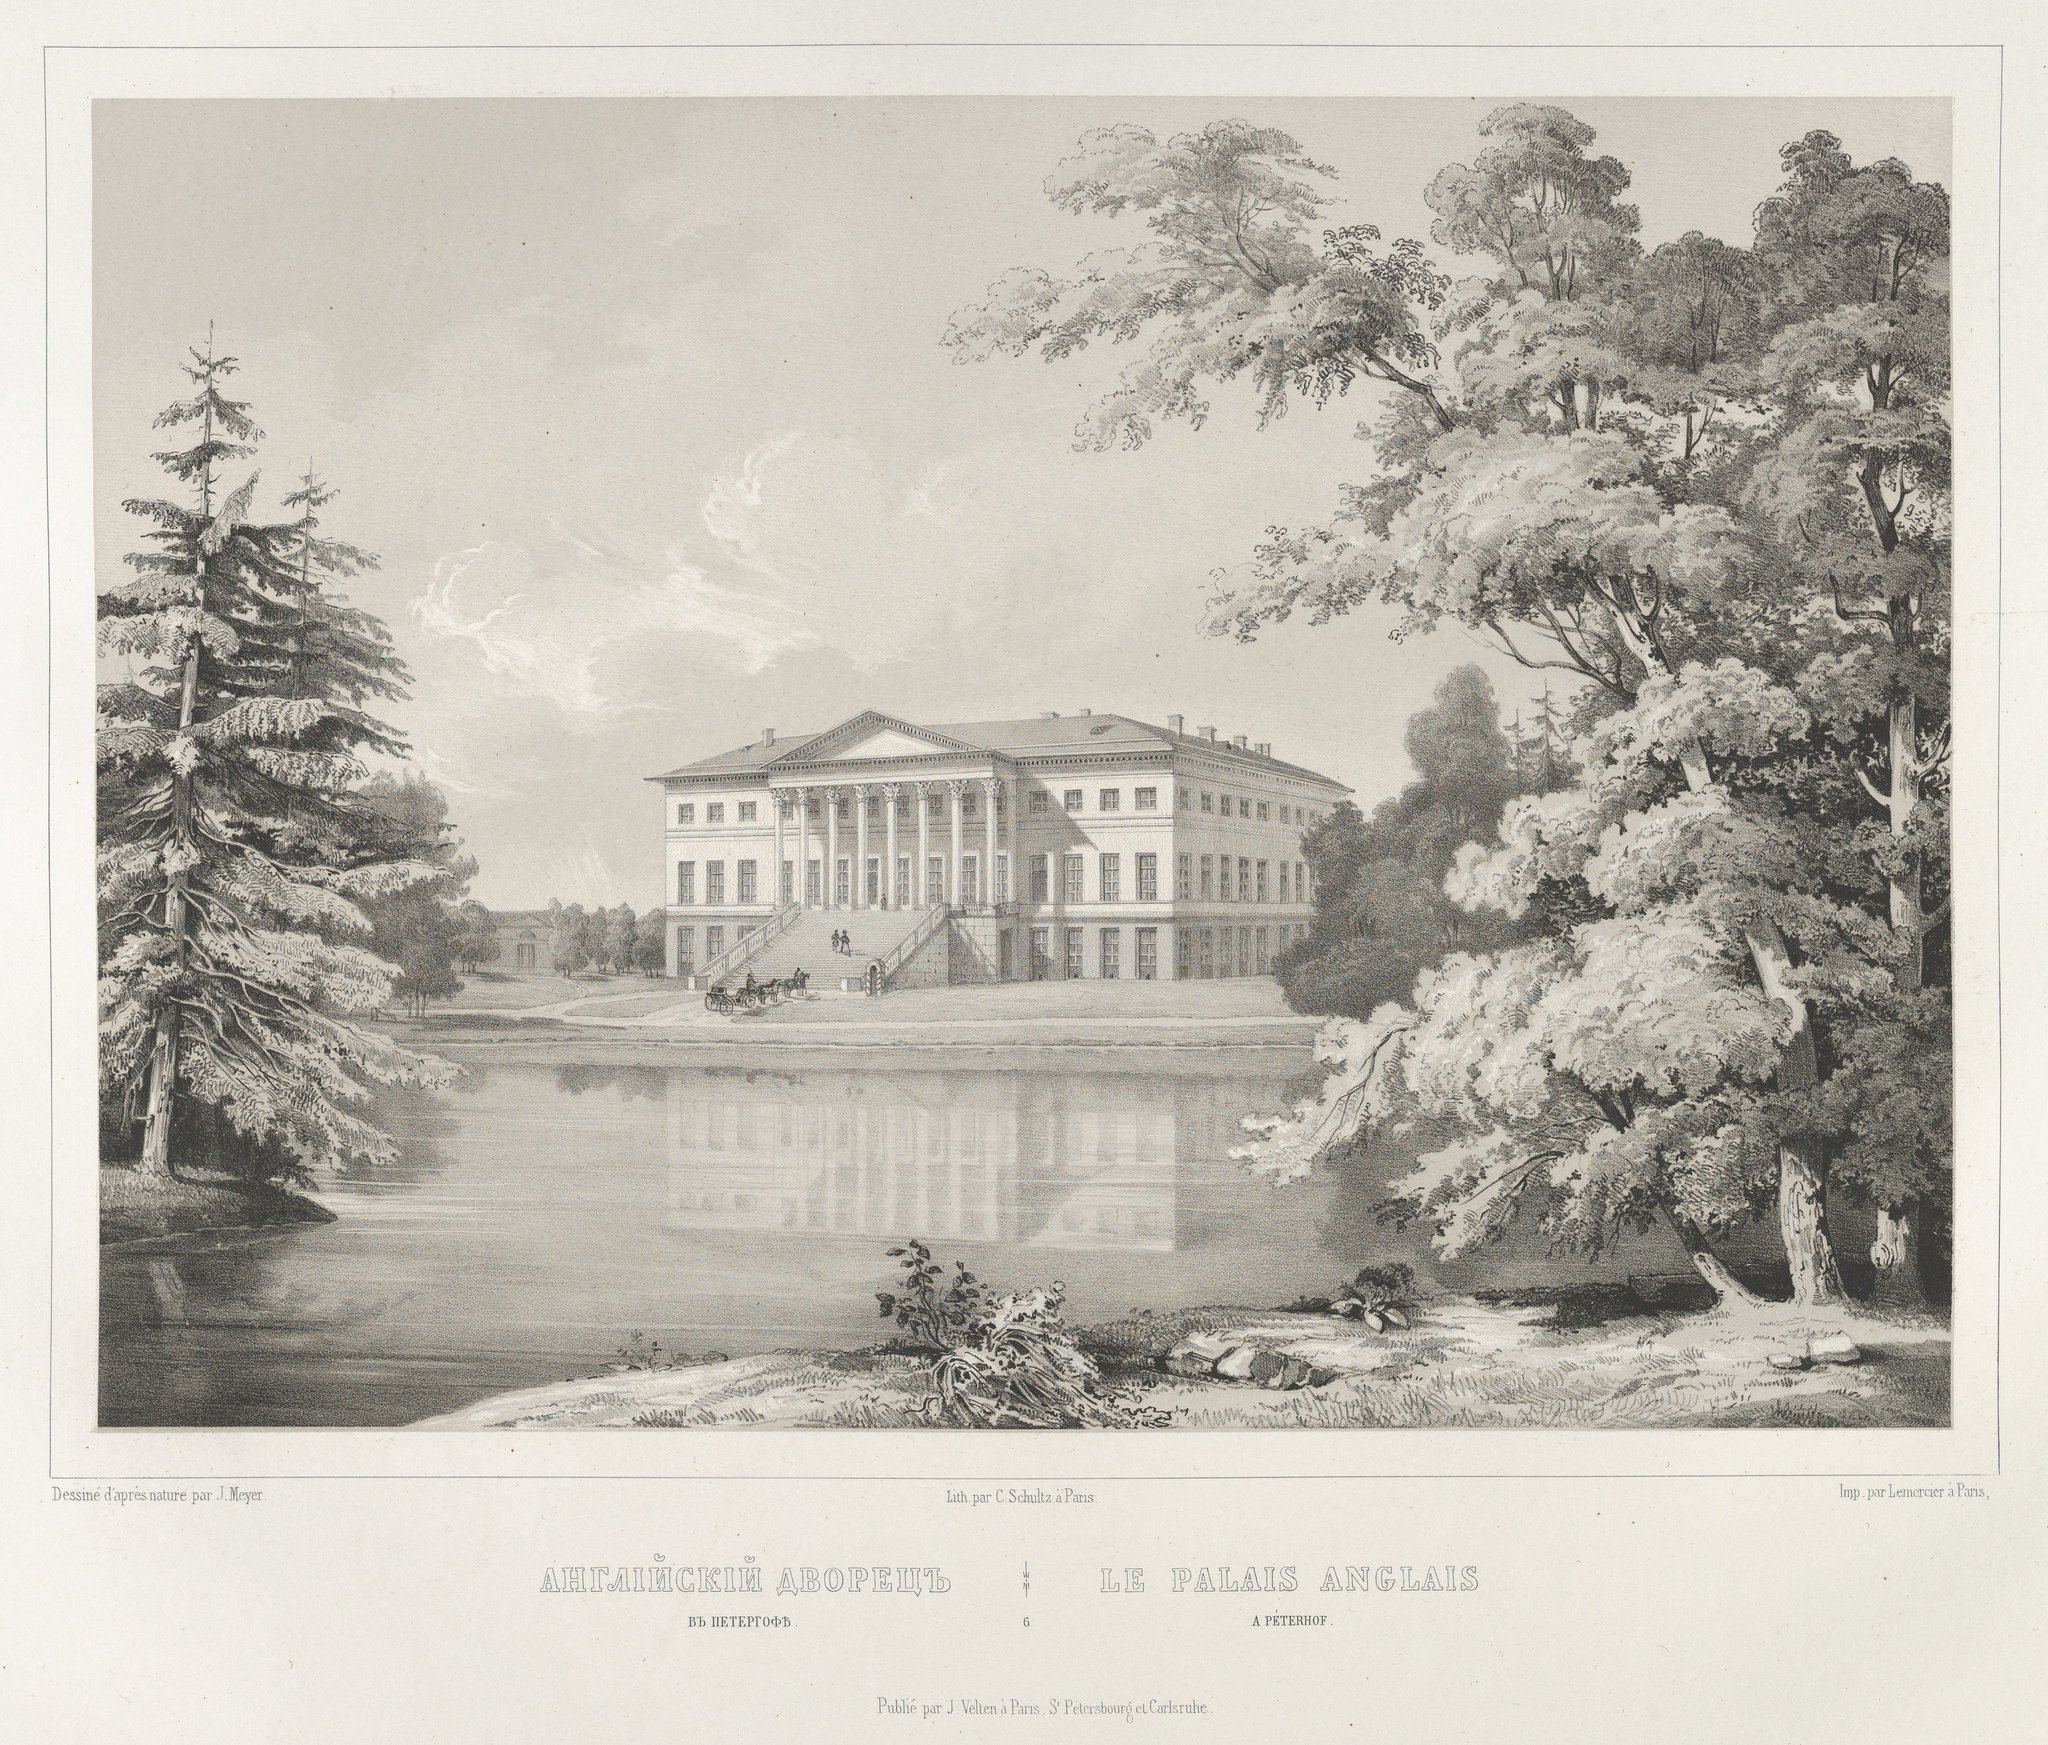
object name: print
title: Le Palais Anglais à Peterhof, from "Vues pittoresques des palais & jardins impériaux aux environs de St. Petersbourg"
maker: j. meyer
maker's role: artist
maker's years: 1800-1900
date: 1850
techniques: lithograph, printing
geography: russia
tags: palaces